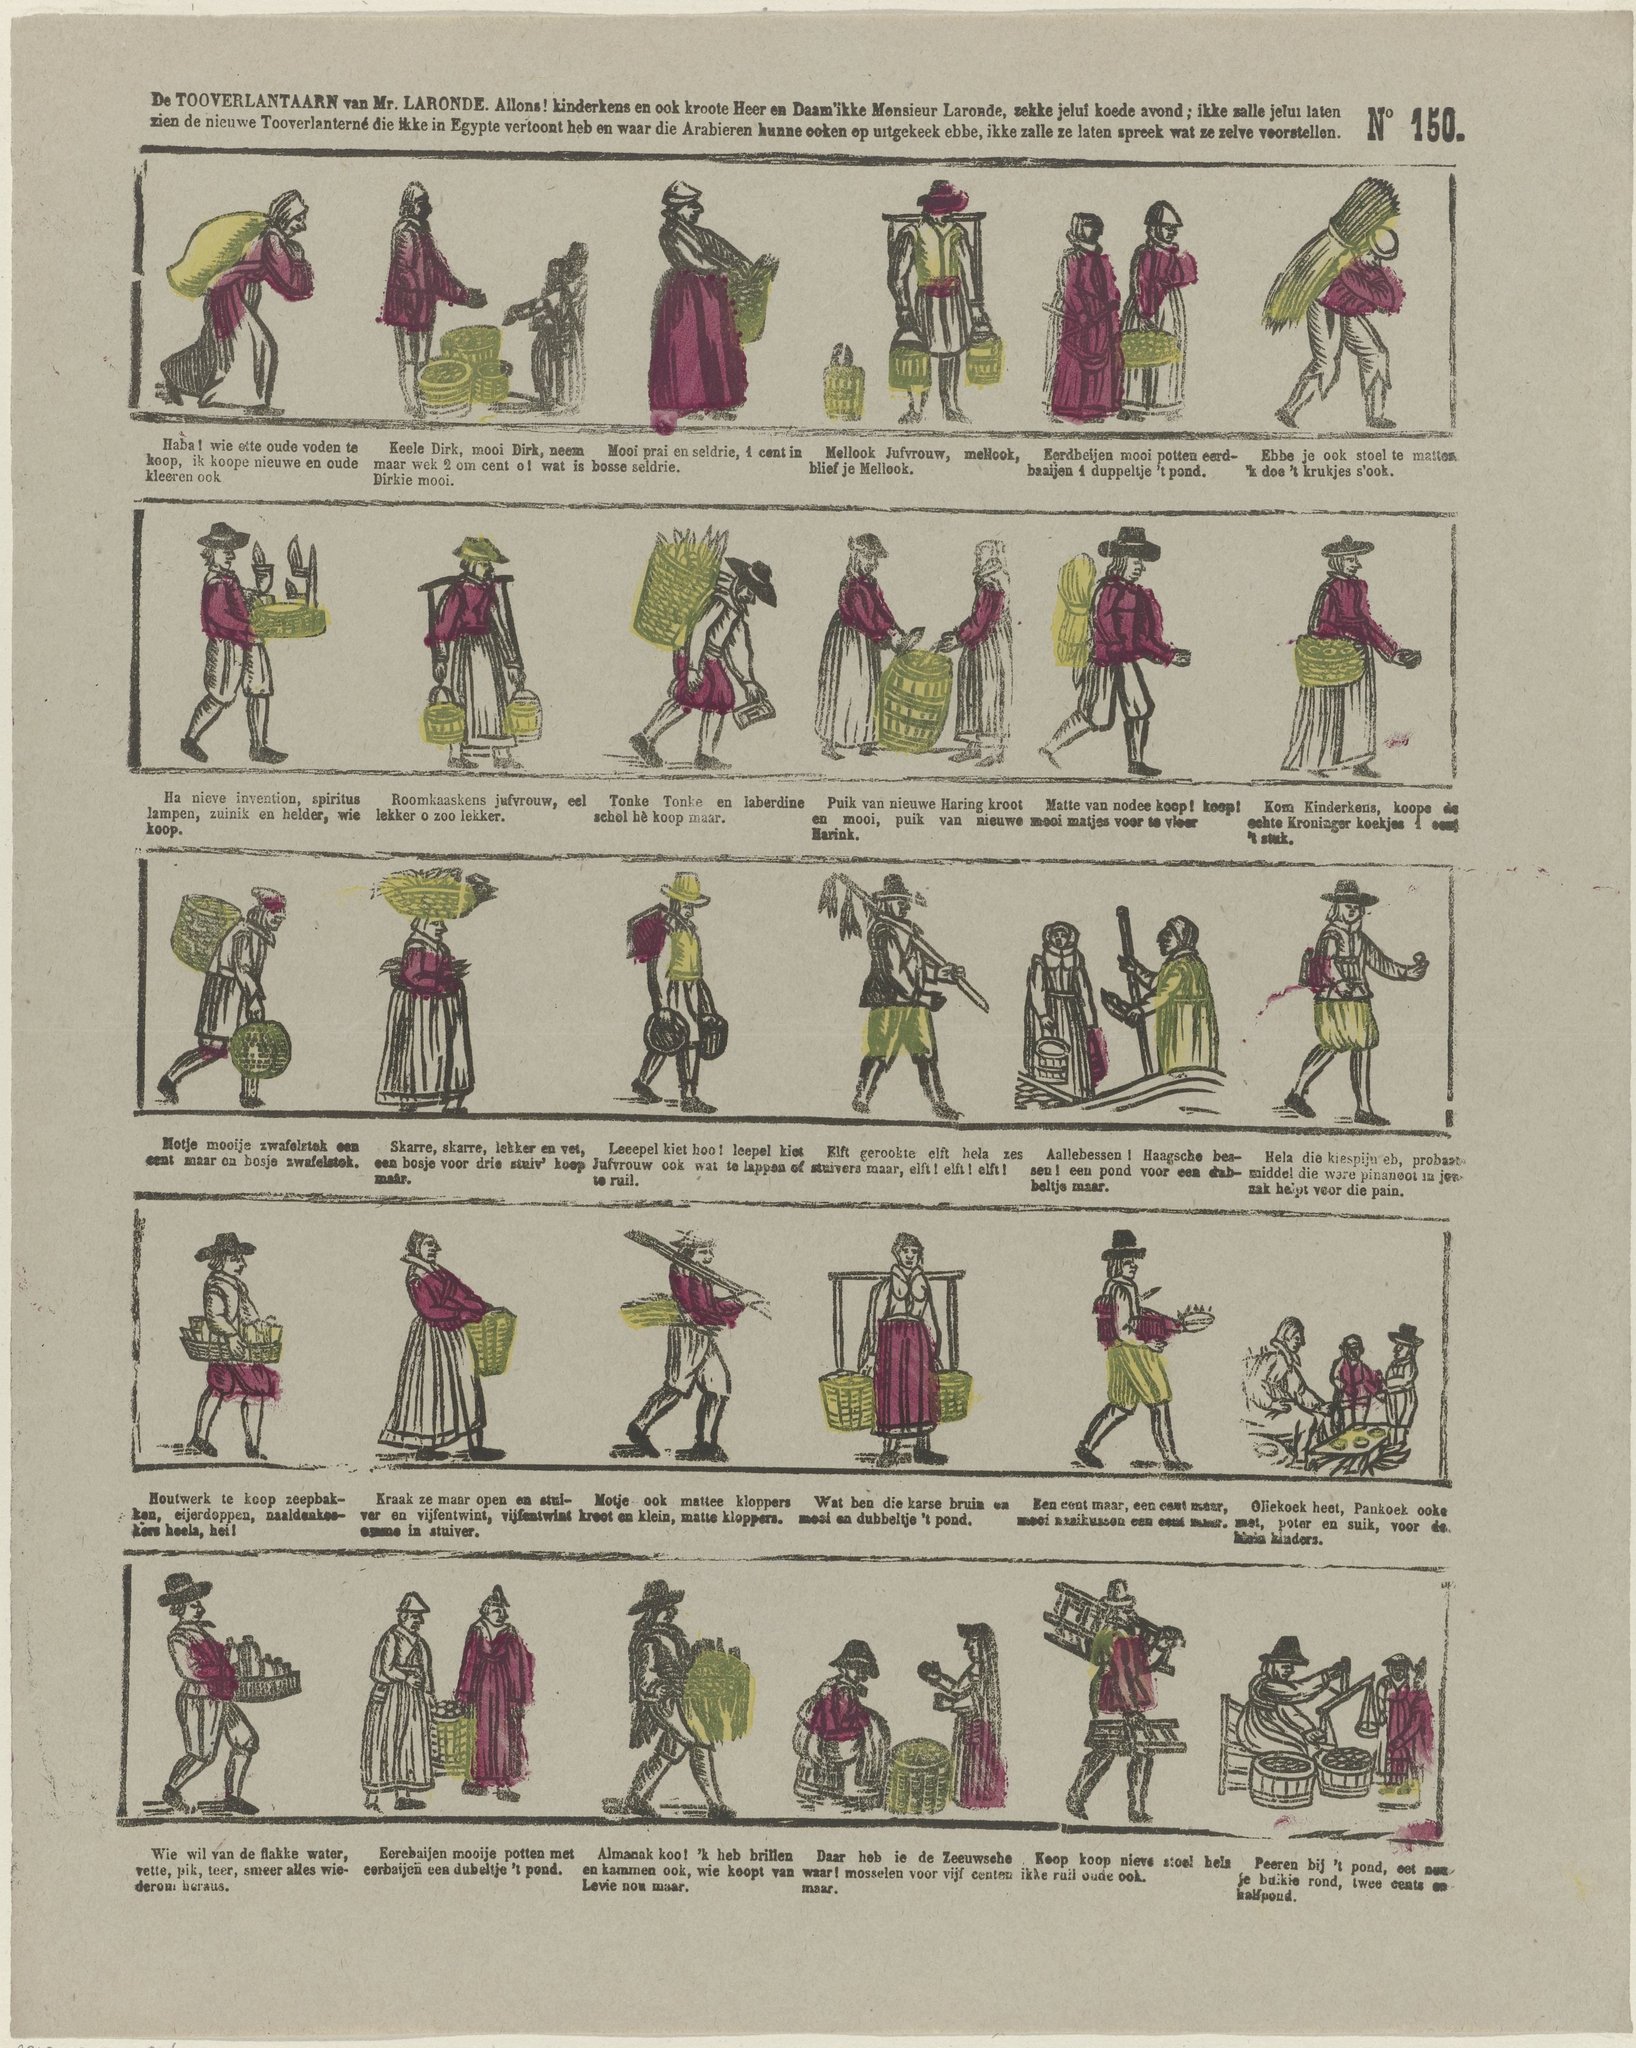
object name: print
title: De tooverlantaarn van Mr. Laronde [(...)]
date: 1827-1894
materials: paper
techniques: colour, letterpress printing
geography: schaarbeek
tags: street-trader, merchant, salesman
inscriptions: collector's mark: Lugt 2760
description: Blad met 5 horizontale rijen met voorstellingen van straatverkopers. Onder elke afbeelding een onderschrift. Genummerd rechtsboven: No 150.